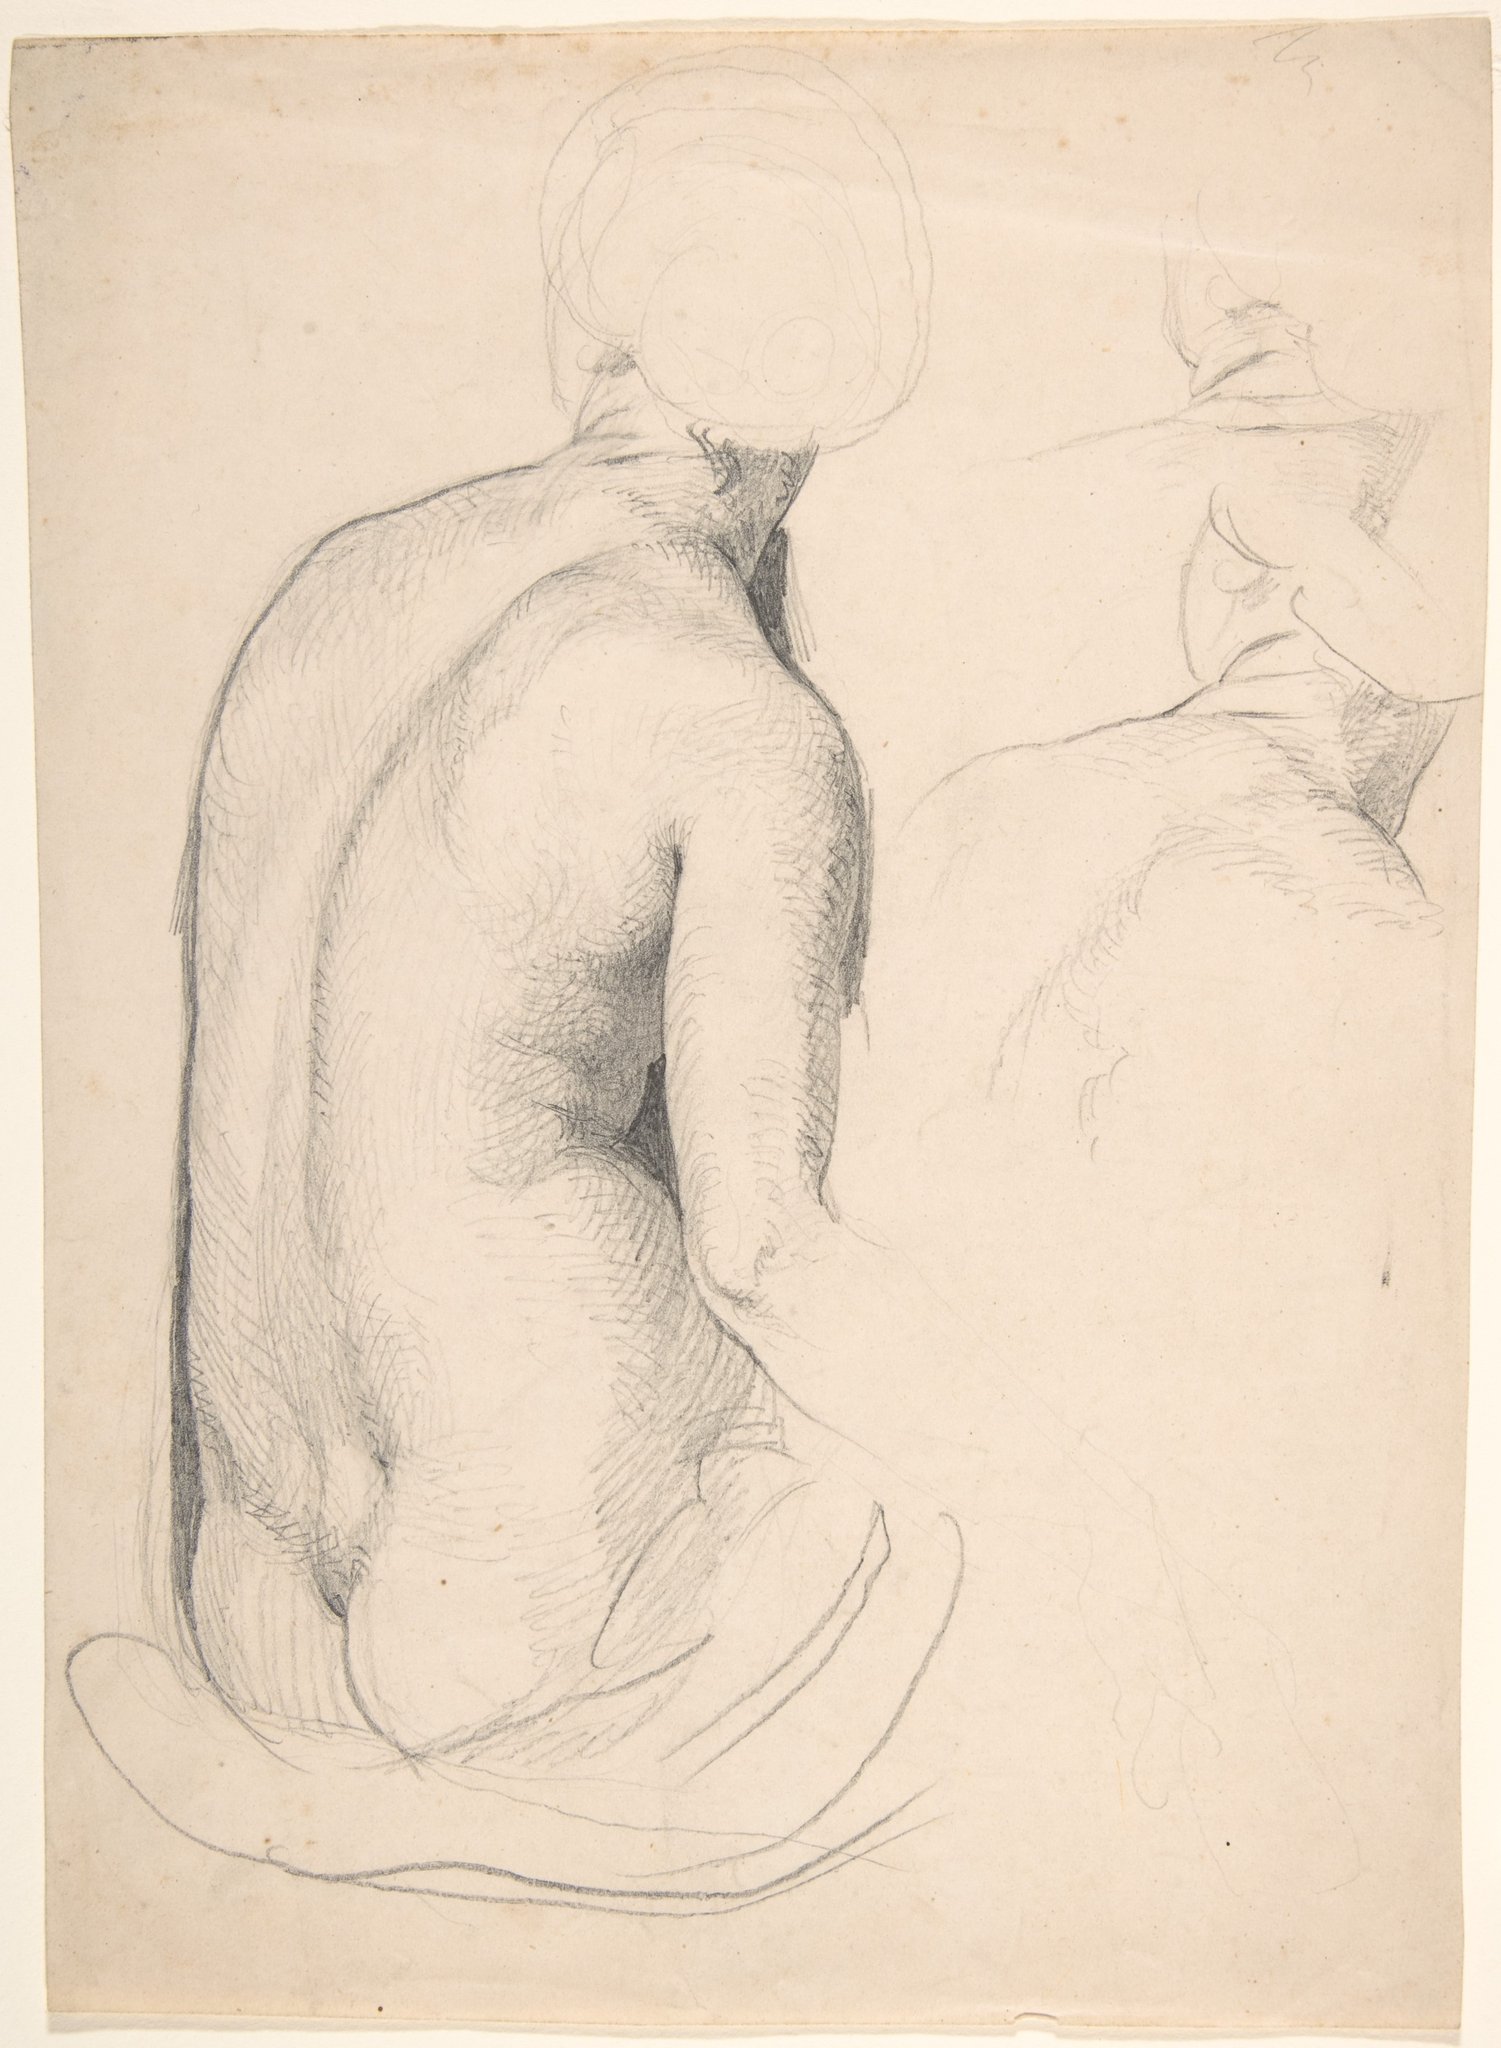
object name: drawing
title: Studies of a Seated Woman from Behind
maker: eduard julius friedrich bendemann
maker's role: artist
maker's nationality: german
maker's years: 1811-1889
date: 1811-1889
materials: graphite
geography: germany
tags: female nudes